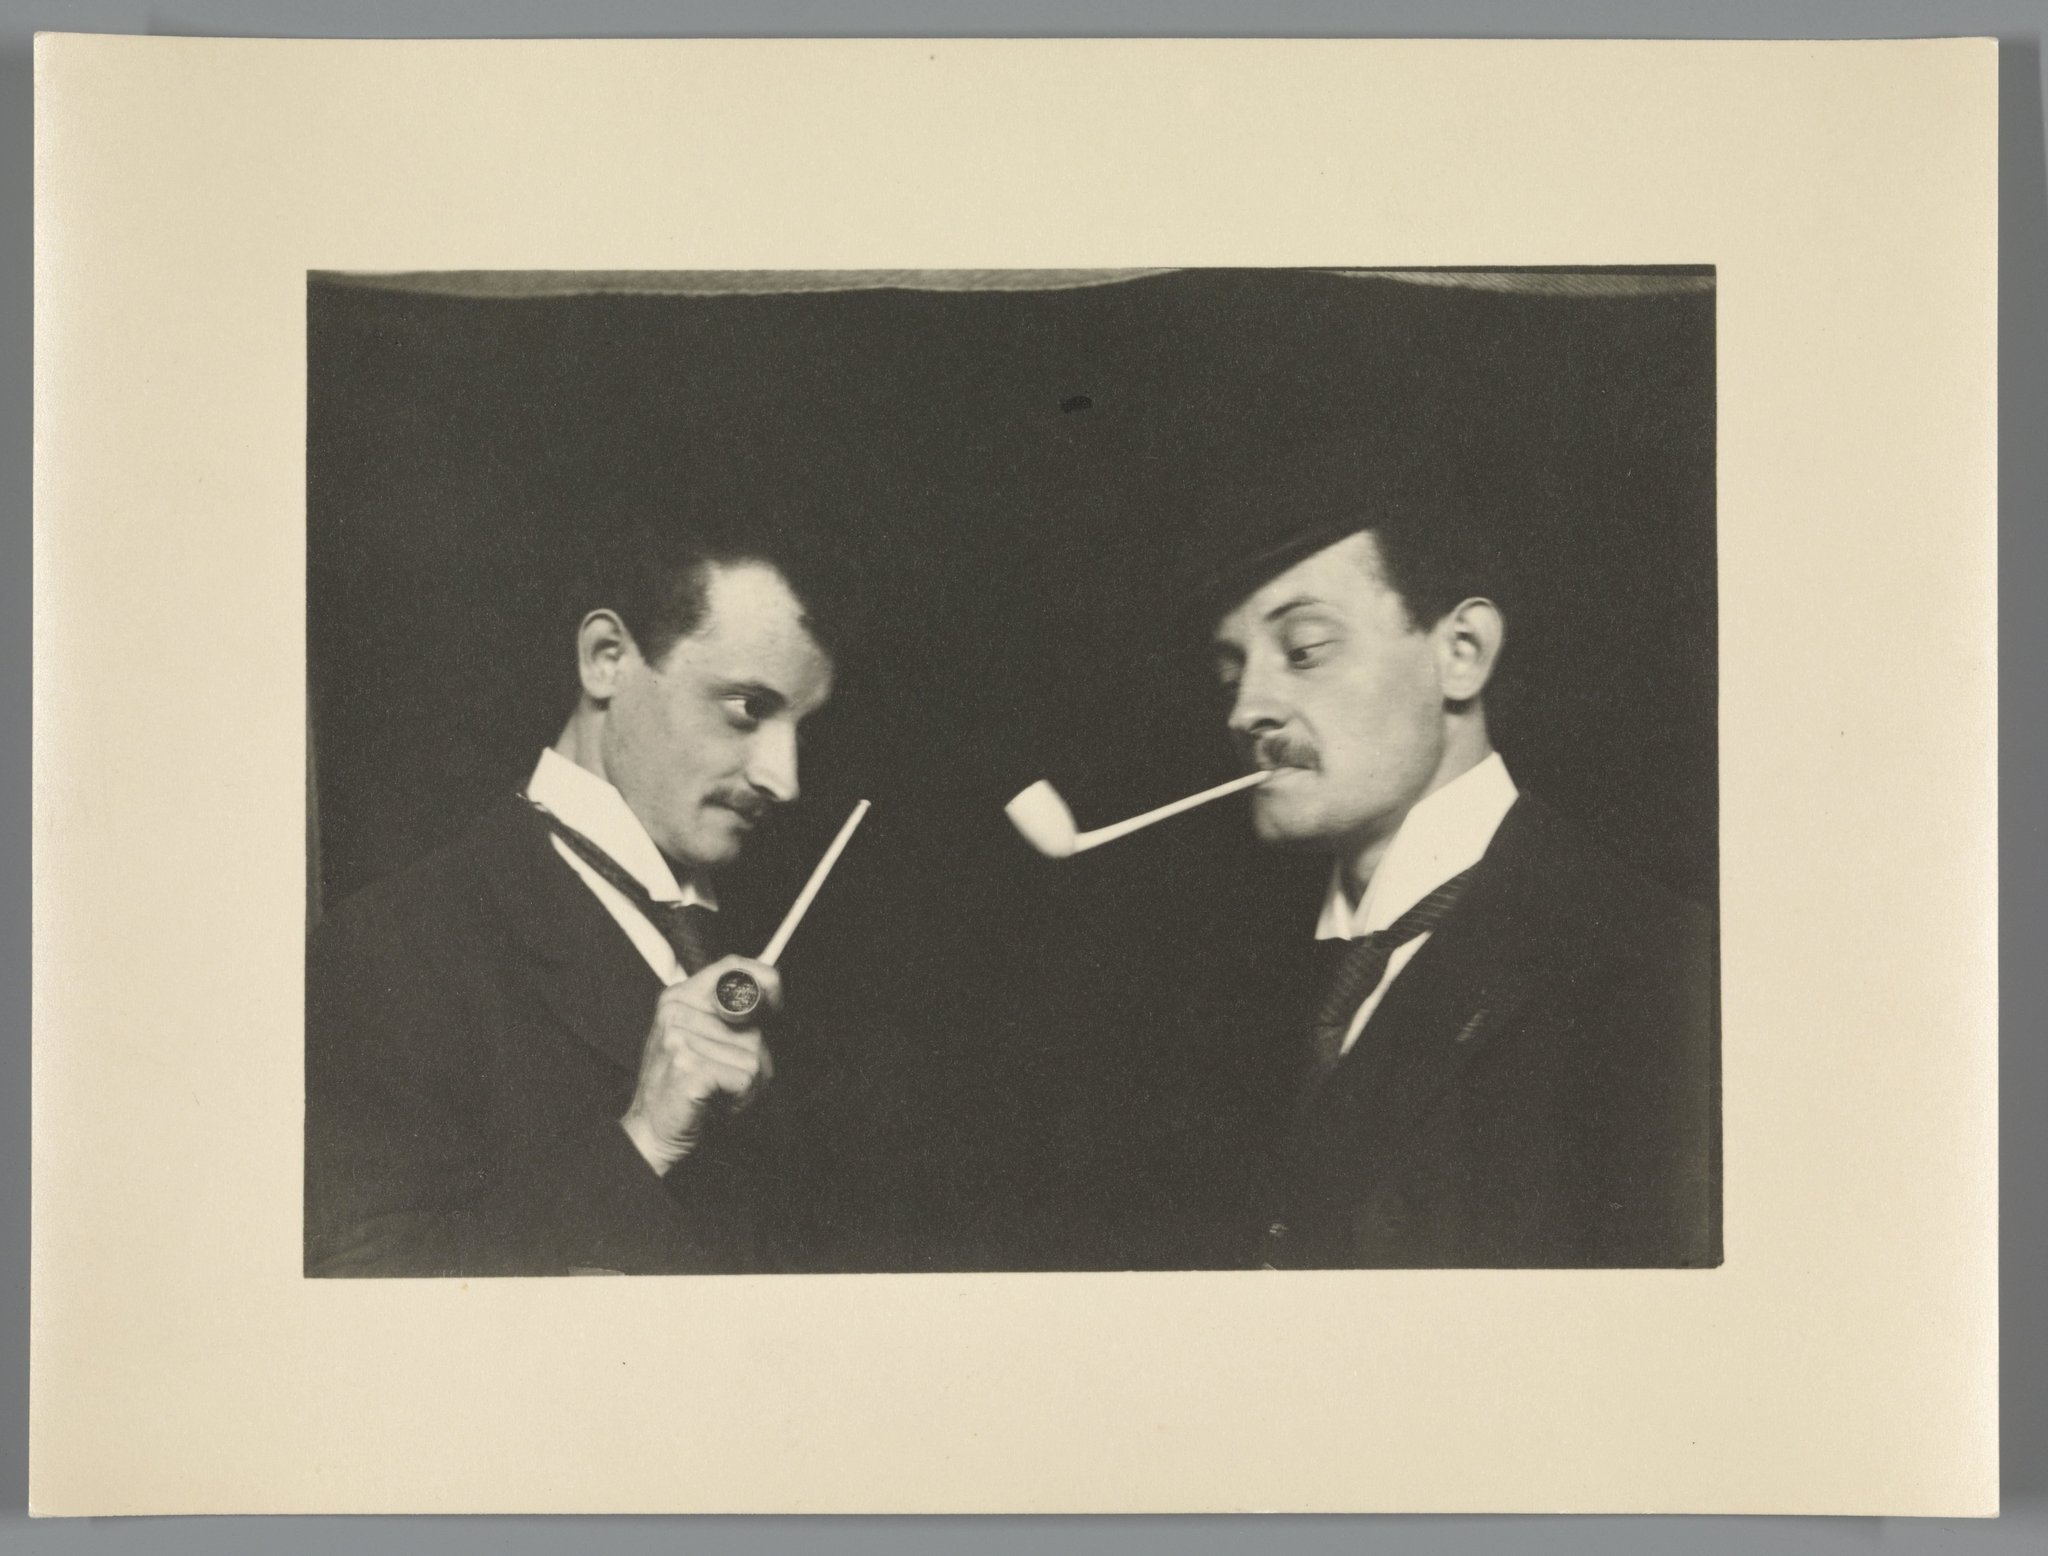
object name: photograph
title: Reproductie naar een foto van Willem Witsen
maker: Anonymous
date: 1860-1915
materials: paper, photographic support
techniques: gelatin silver print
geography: netherlands